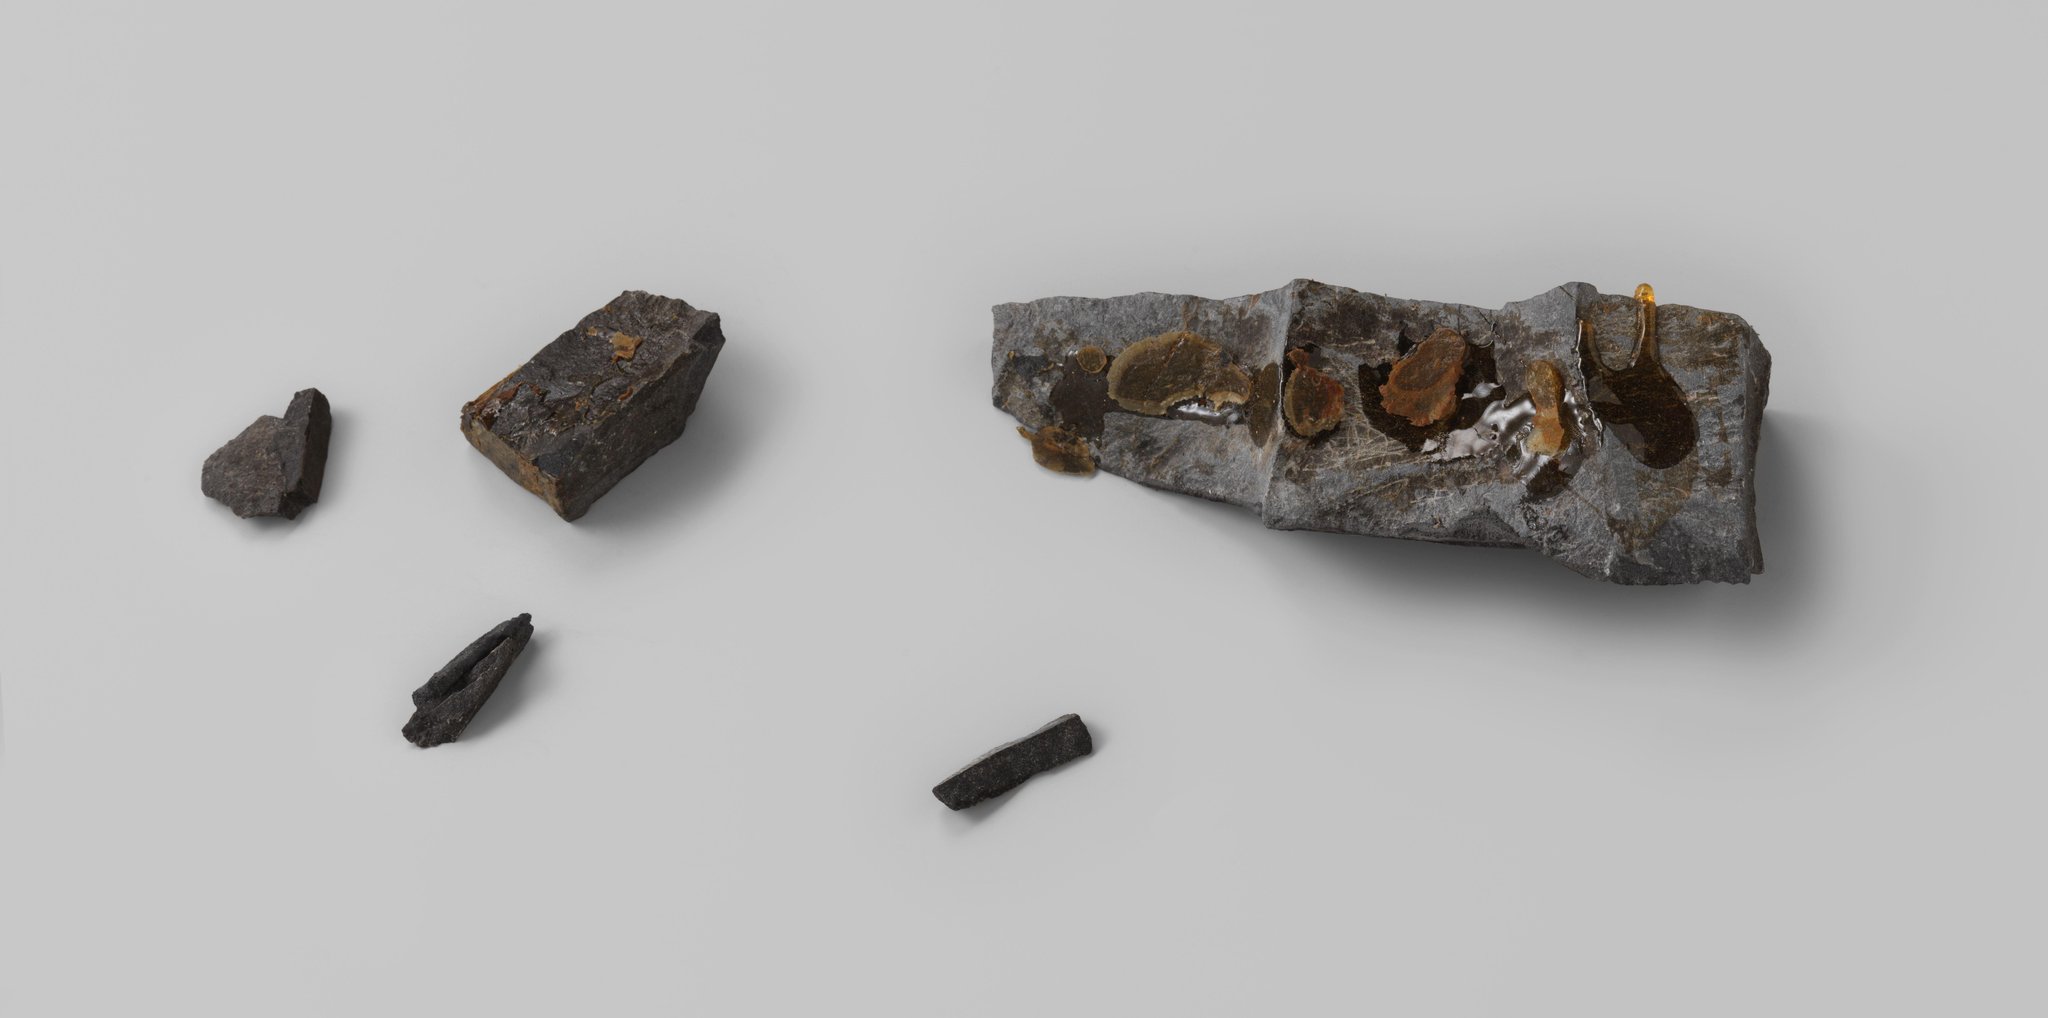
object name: tomb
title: Tomb of Arnold van der Sluis of Heusden, Knight (c. 1245-1296)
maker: Anonymous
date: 1296-1325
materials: limestone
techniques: carved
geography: meuse area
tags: bern (gelderland)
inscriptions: coat of arms, inscription: ‘[Qui fuerat gratus cun]ctis iac[et] h[ic] tumulat[us] Husde[n]si nat[us] ex clara stirpe vocat[us] Arnold[us] mile[s] de slusa sp[er]ne[re] viles Act[us] h[ic] novit falso[s] [a] seque removit Fortis formosus prudens erat atque animosus Justus pacifuc probitati semper amicus Finiit is vitam morum gravitate p]olita[m] Q[ua]rto redde[n]das a mense dec[em]bre kale[n]das. An[n]o milleno d[omi]ni noviesq[ue] noveno Et bis centeno terno quo[que] cu[m] duedeno Gaudeat in c[oelis ut hoc orat] quis[que] fidelis Hoc pater et flamen sacrum nat[us]q[ue] [det amen]’, coat of arms, in reliëf, coat of arms, in relief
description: Onderdeel van de dekselplaat van de graftombe van Ridder Arnold van der Sluis van Heusden.